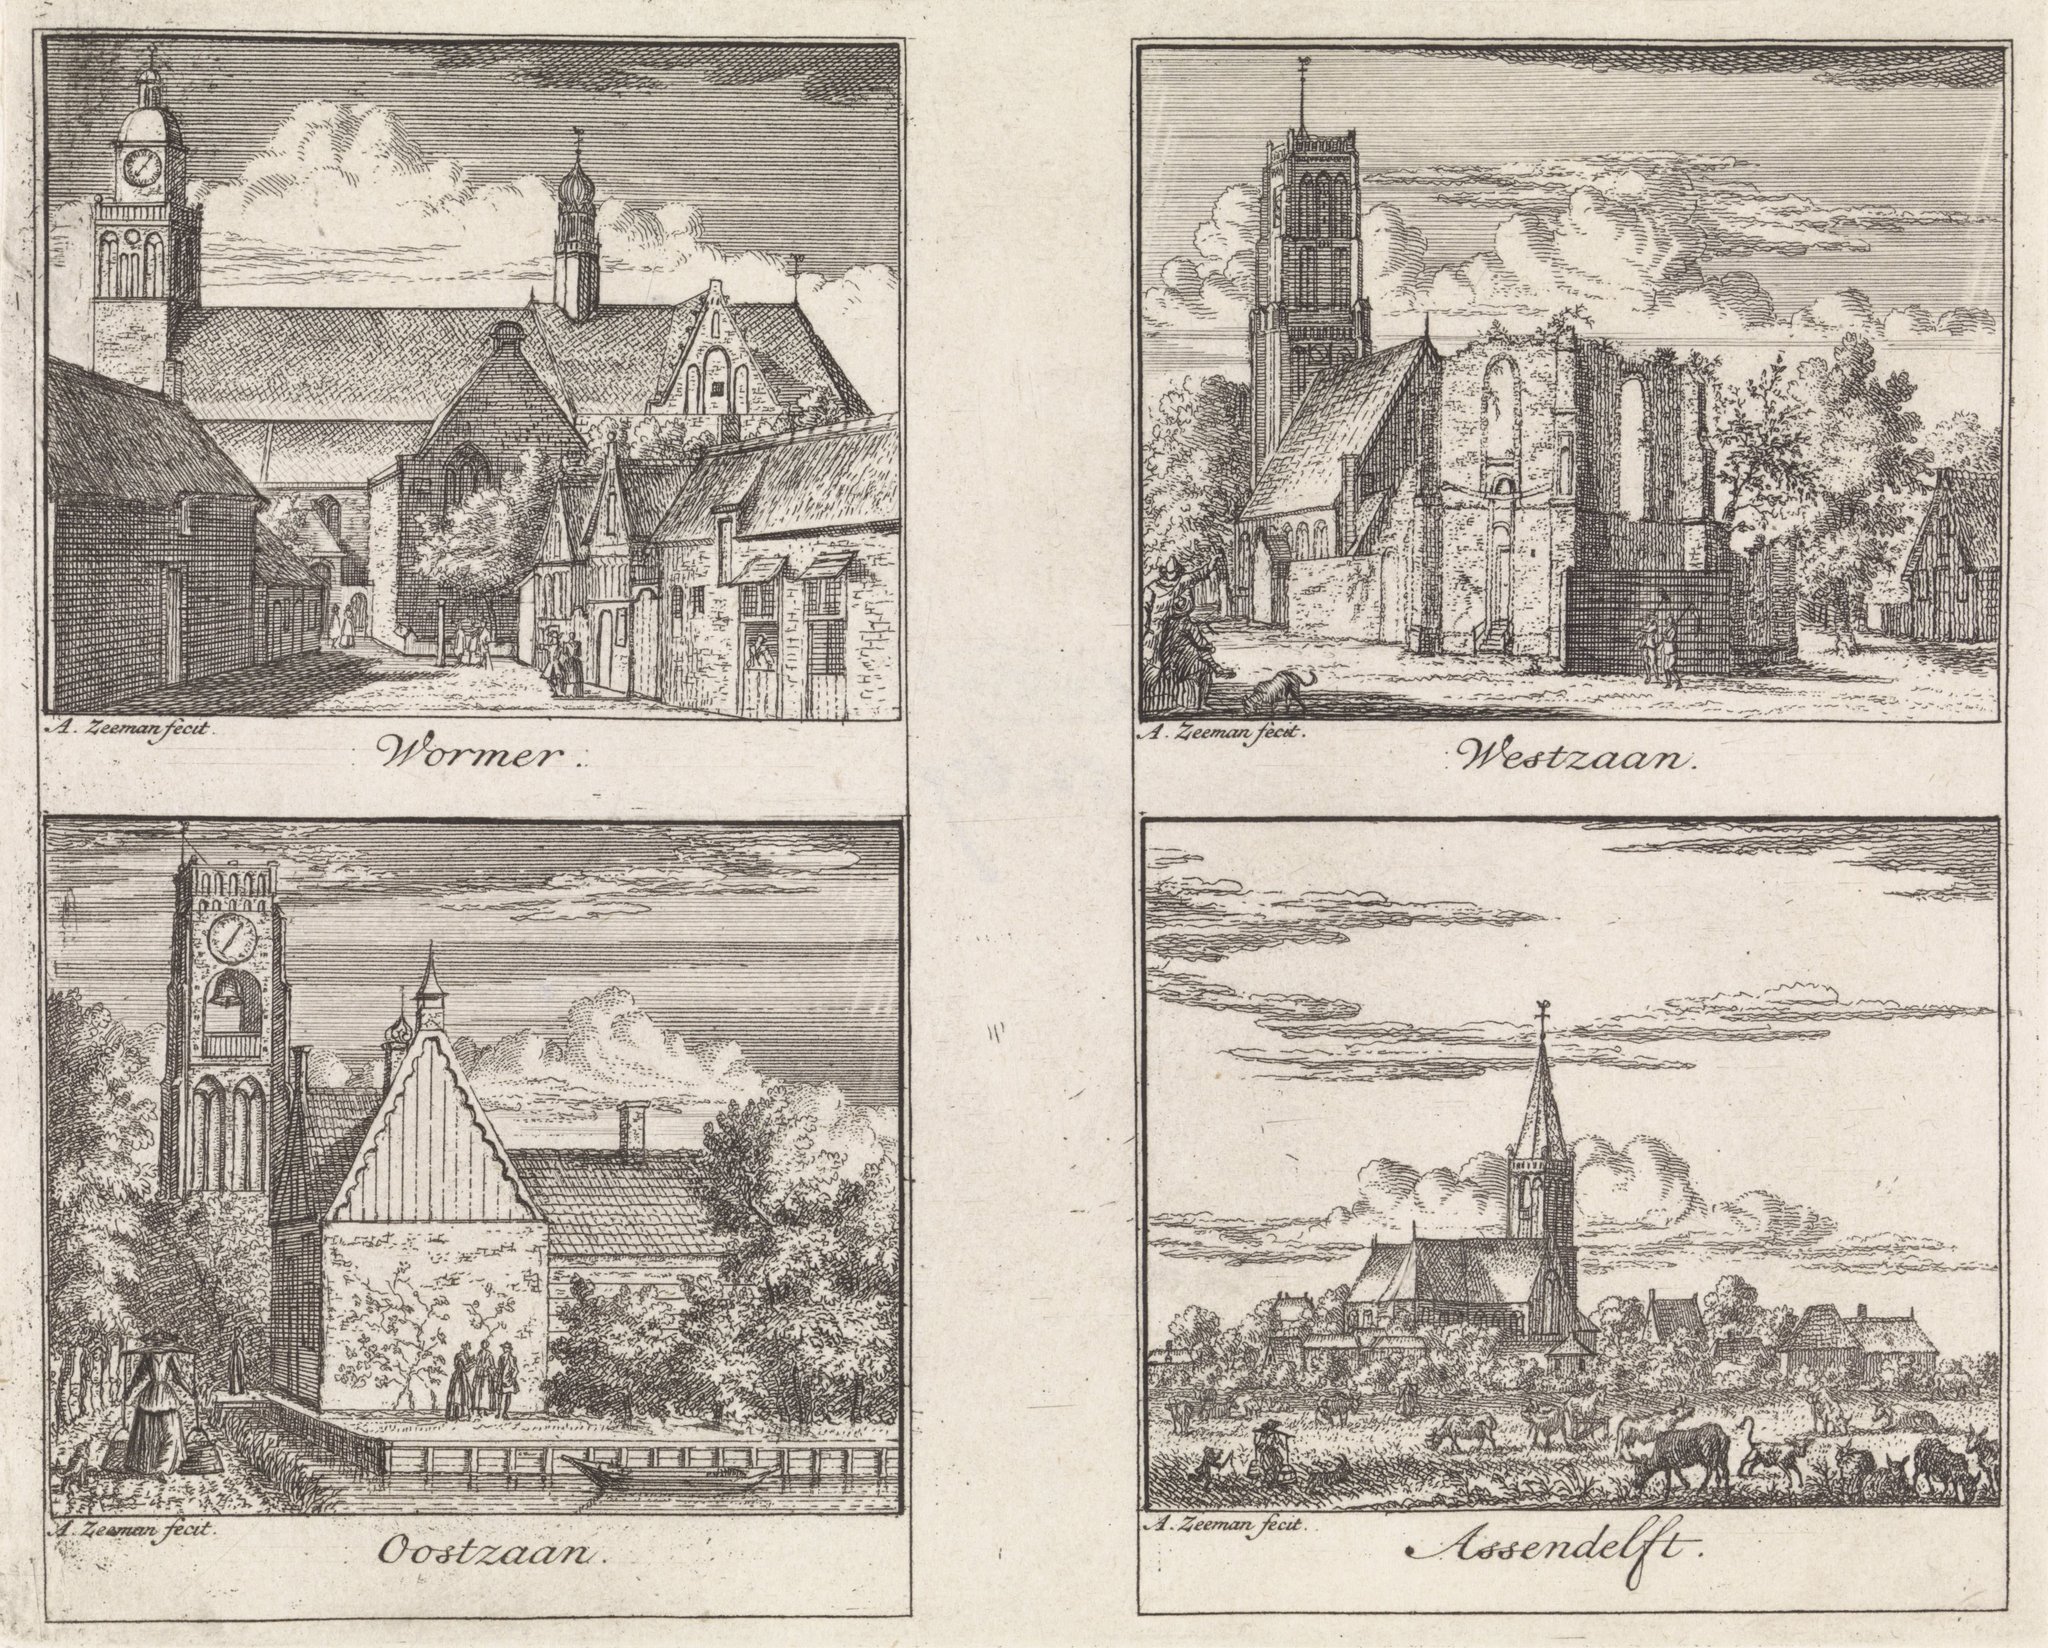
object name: print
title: Gezichten op Wormer, Oostzaan, Westzaan en Assendelft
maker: abraham zeeman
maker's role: print maker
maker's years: 1695-1754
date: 1732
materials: paper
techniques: etching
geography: amsterdam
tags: prospect of village, silhouette of village, church (exterior), assendelft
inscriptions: collector's mark: Lugt 2228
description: Vier voorstellingen op een blad. Linksboven: Gezicht op de kerk van Wormer. Linksonder: Gezicht op de kerk van Oostzaan. Rechtsboven: Gezicht op de kerk van Westzaan. Rechtsonder: Gezicht op Assendelft.